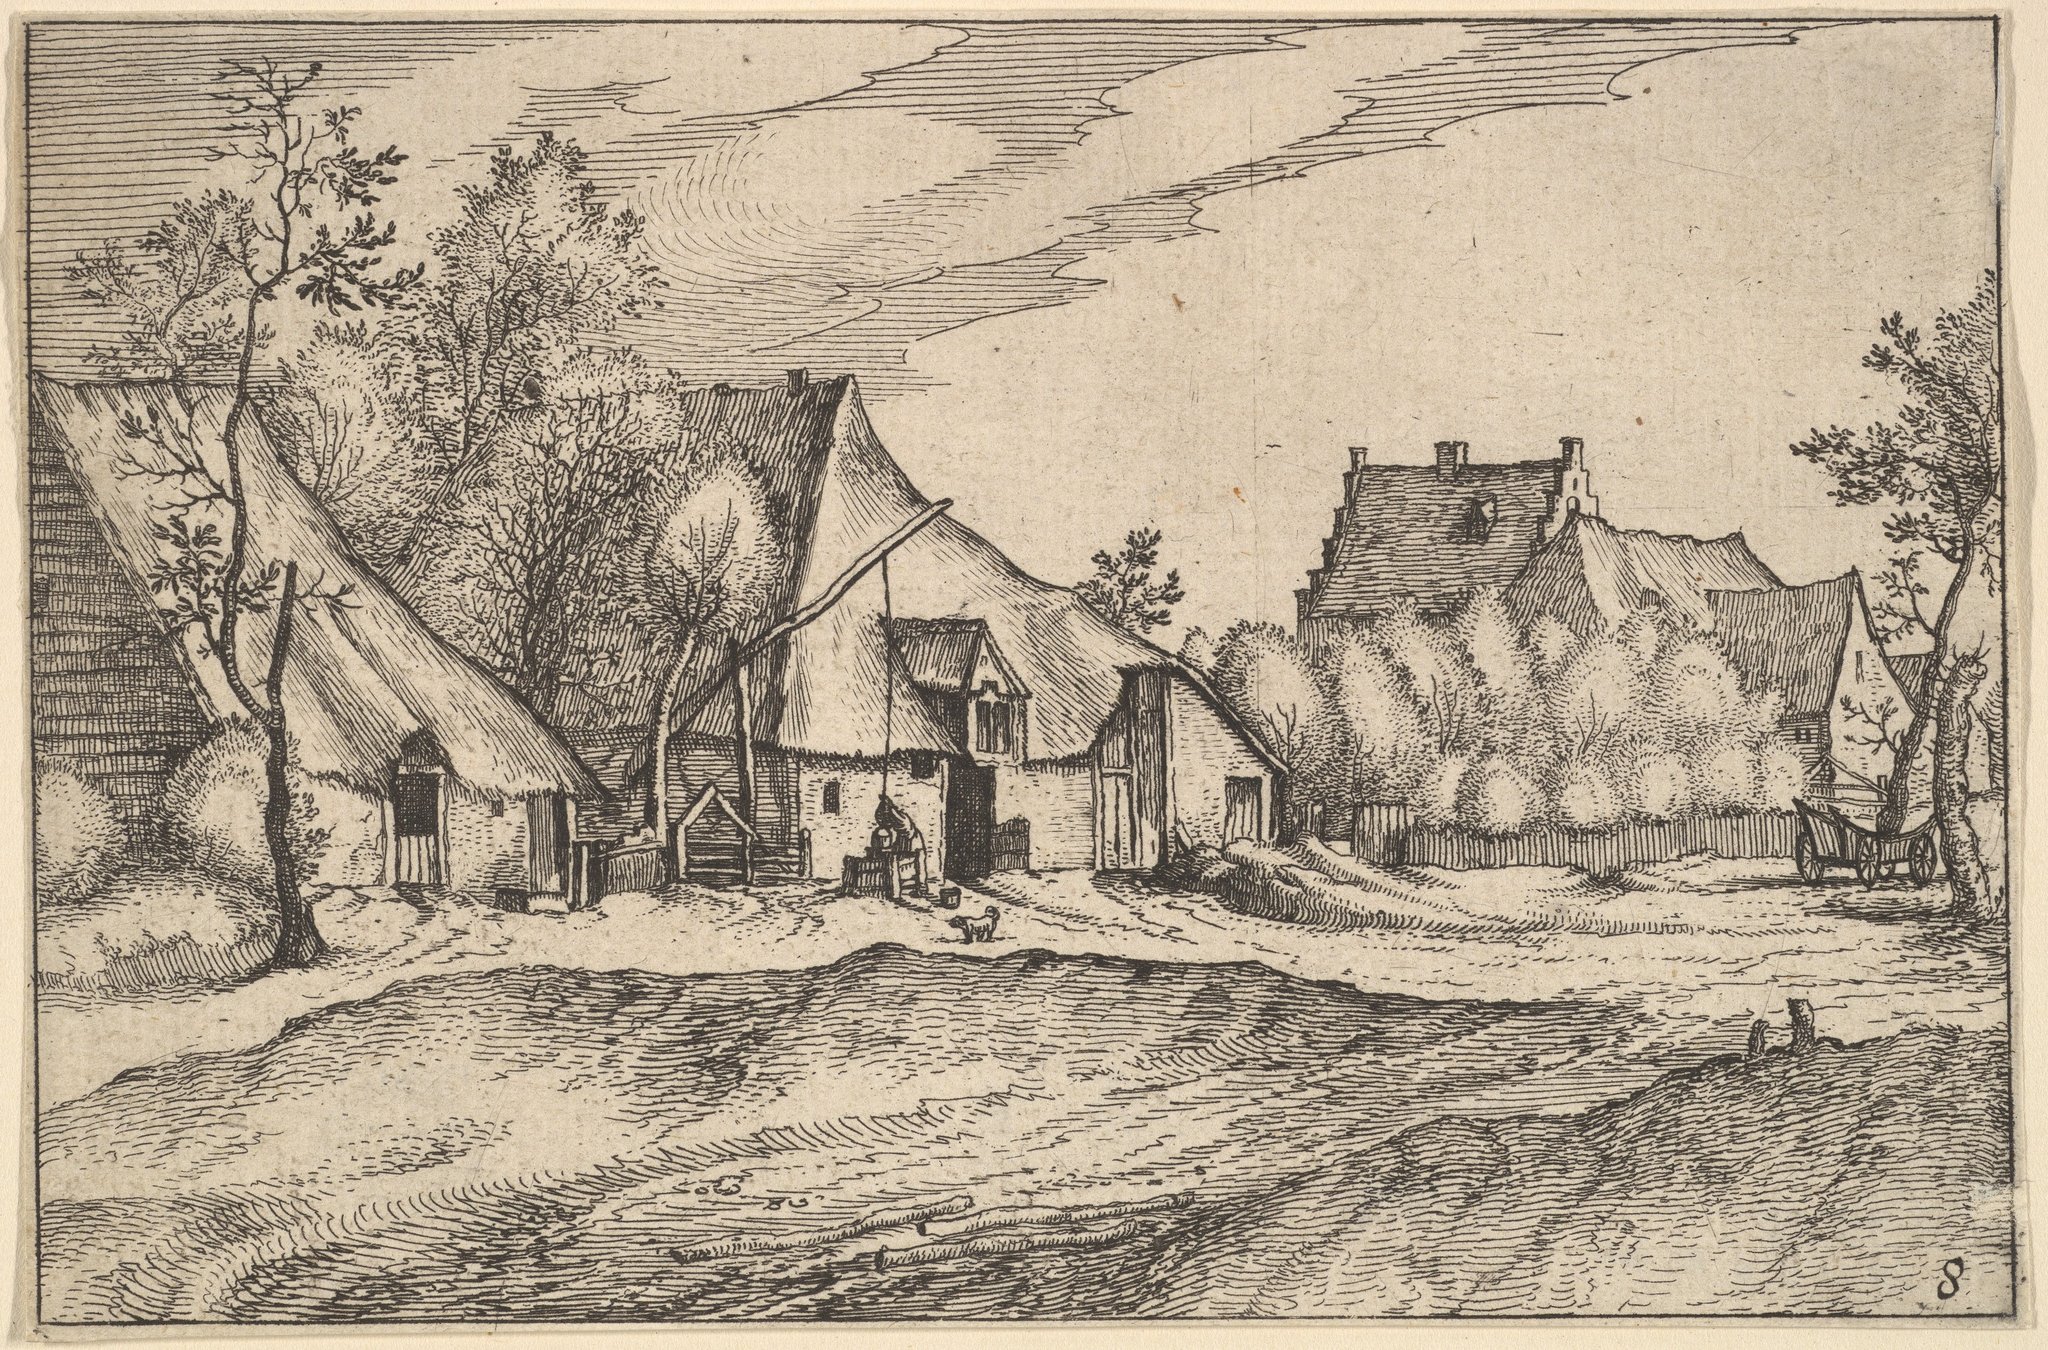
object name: print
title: Farms in a Village from Regiunculae et Villae Aliquot Ducatus Brabantiae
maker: claes jansz. visscher (ii)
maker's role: artist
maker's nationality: dutch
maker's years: 1586-1652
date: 1610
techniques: etching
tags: farms,villages,trees